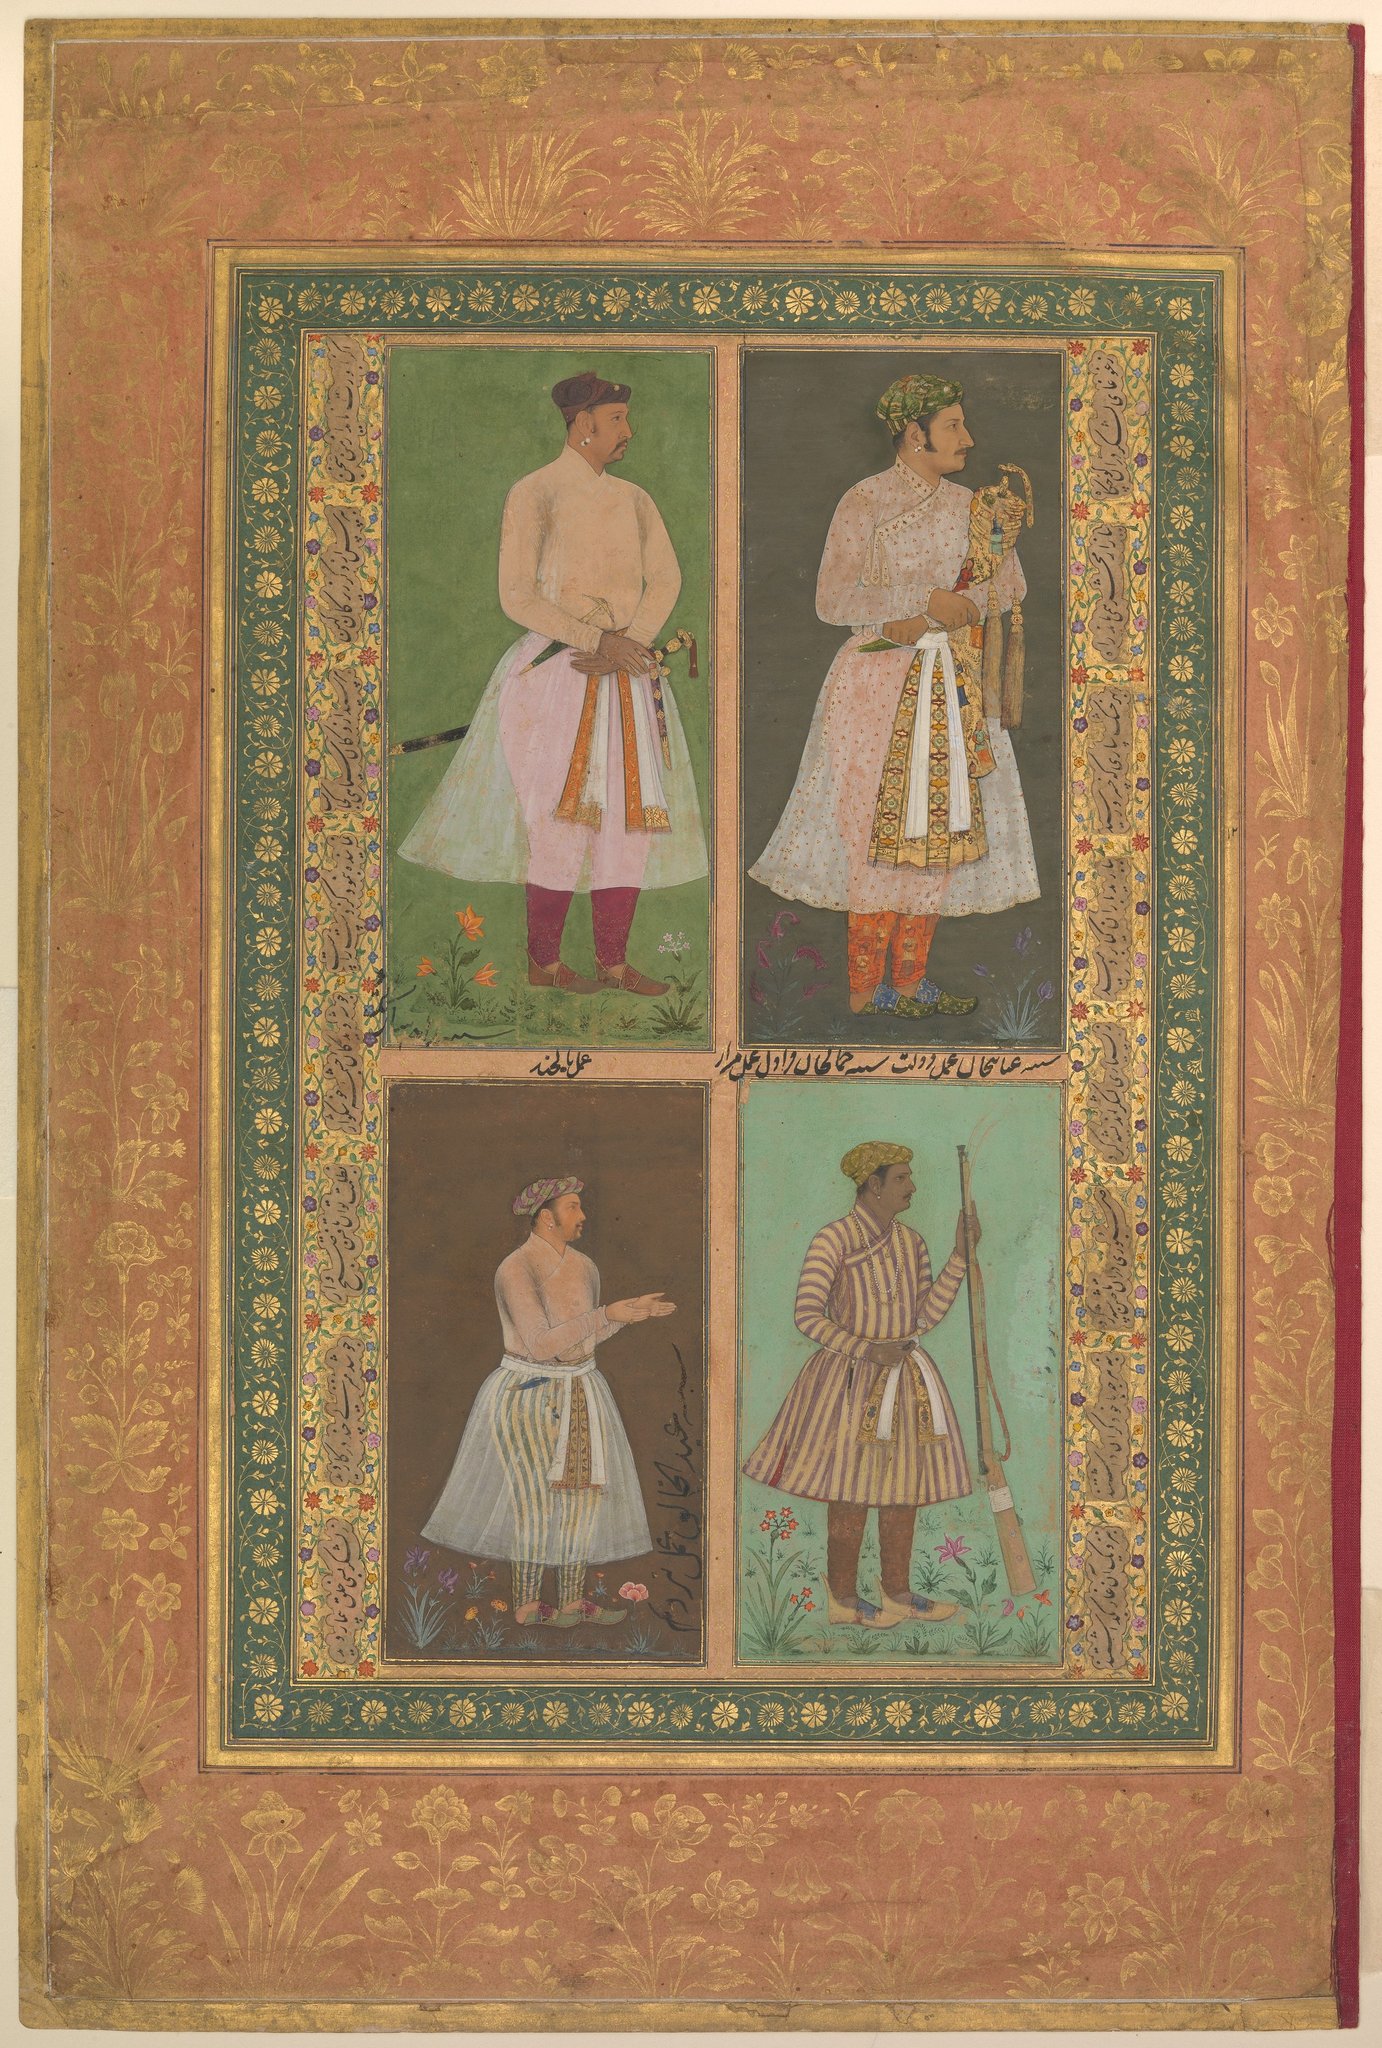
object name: album leaf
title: "Four Portraits: (upper left) A Raja (Perhaps Raja Sarang Rao), by Balchand; (upper right) 'Inayat Khan, by Daulat; (lower left) 'Abd al-Khaliq, probably by Balchand; (lower right) Jamal Khan Qaravul, by Murad", Folio from the Shah Jahan Album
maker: balachand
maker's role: artist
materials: gold, ink, paper, watercolor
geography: india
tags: men,portraits